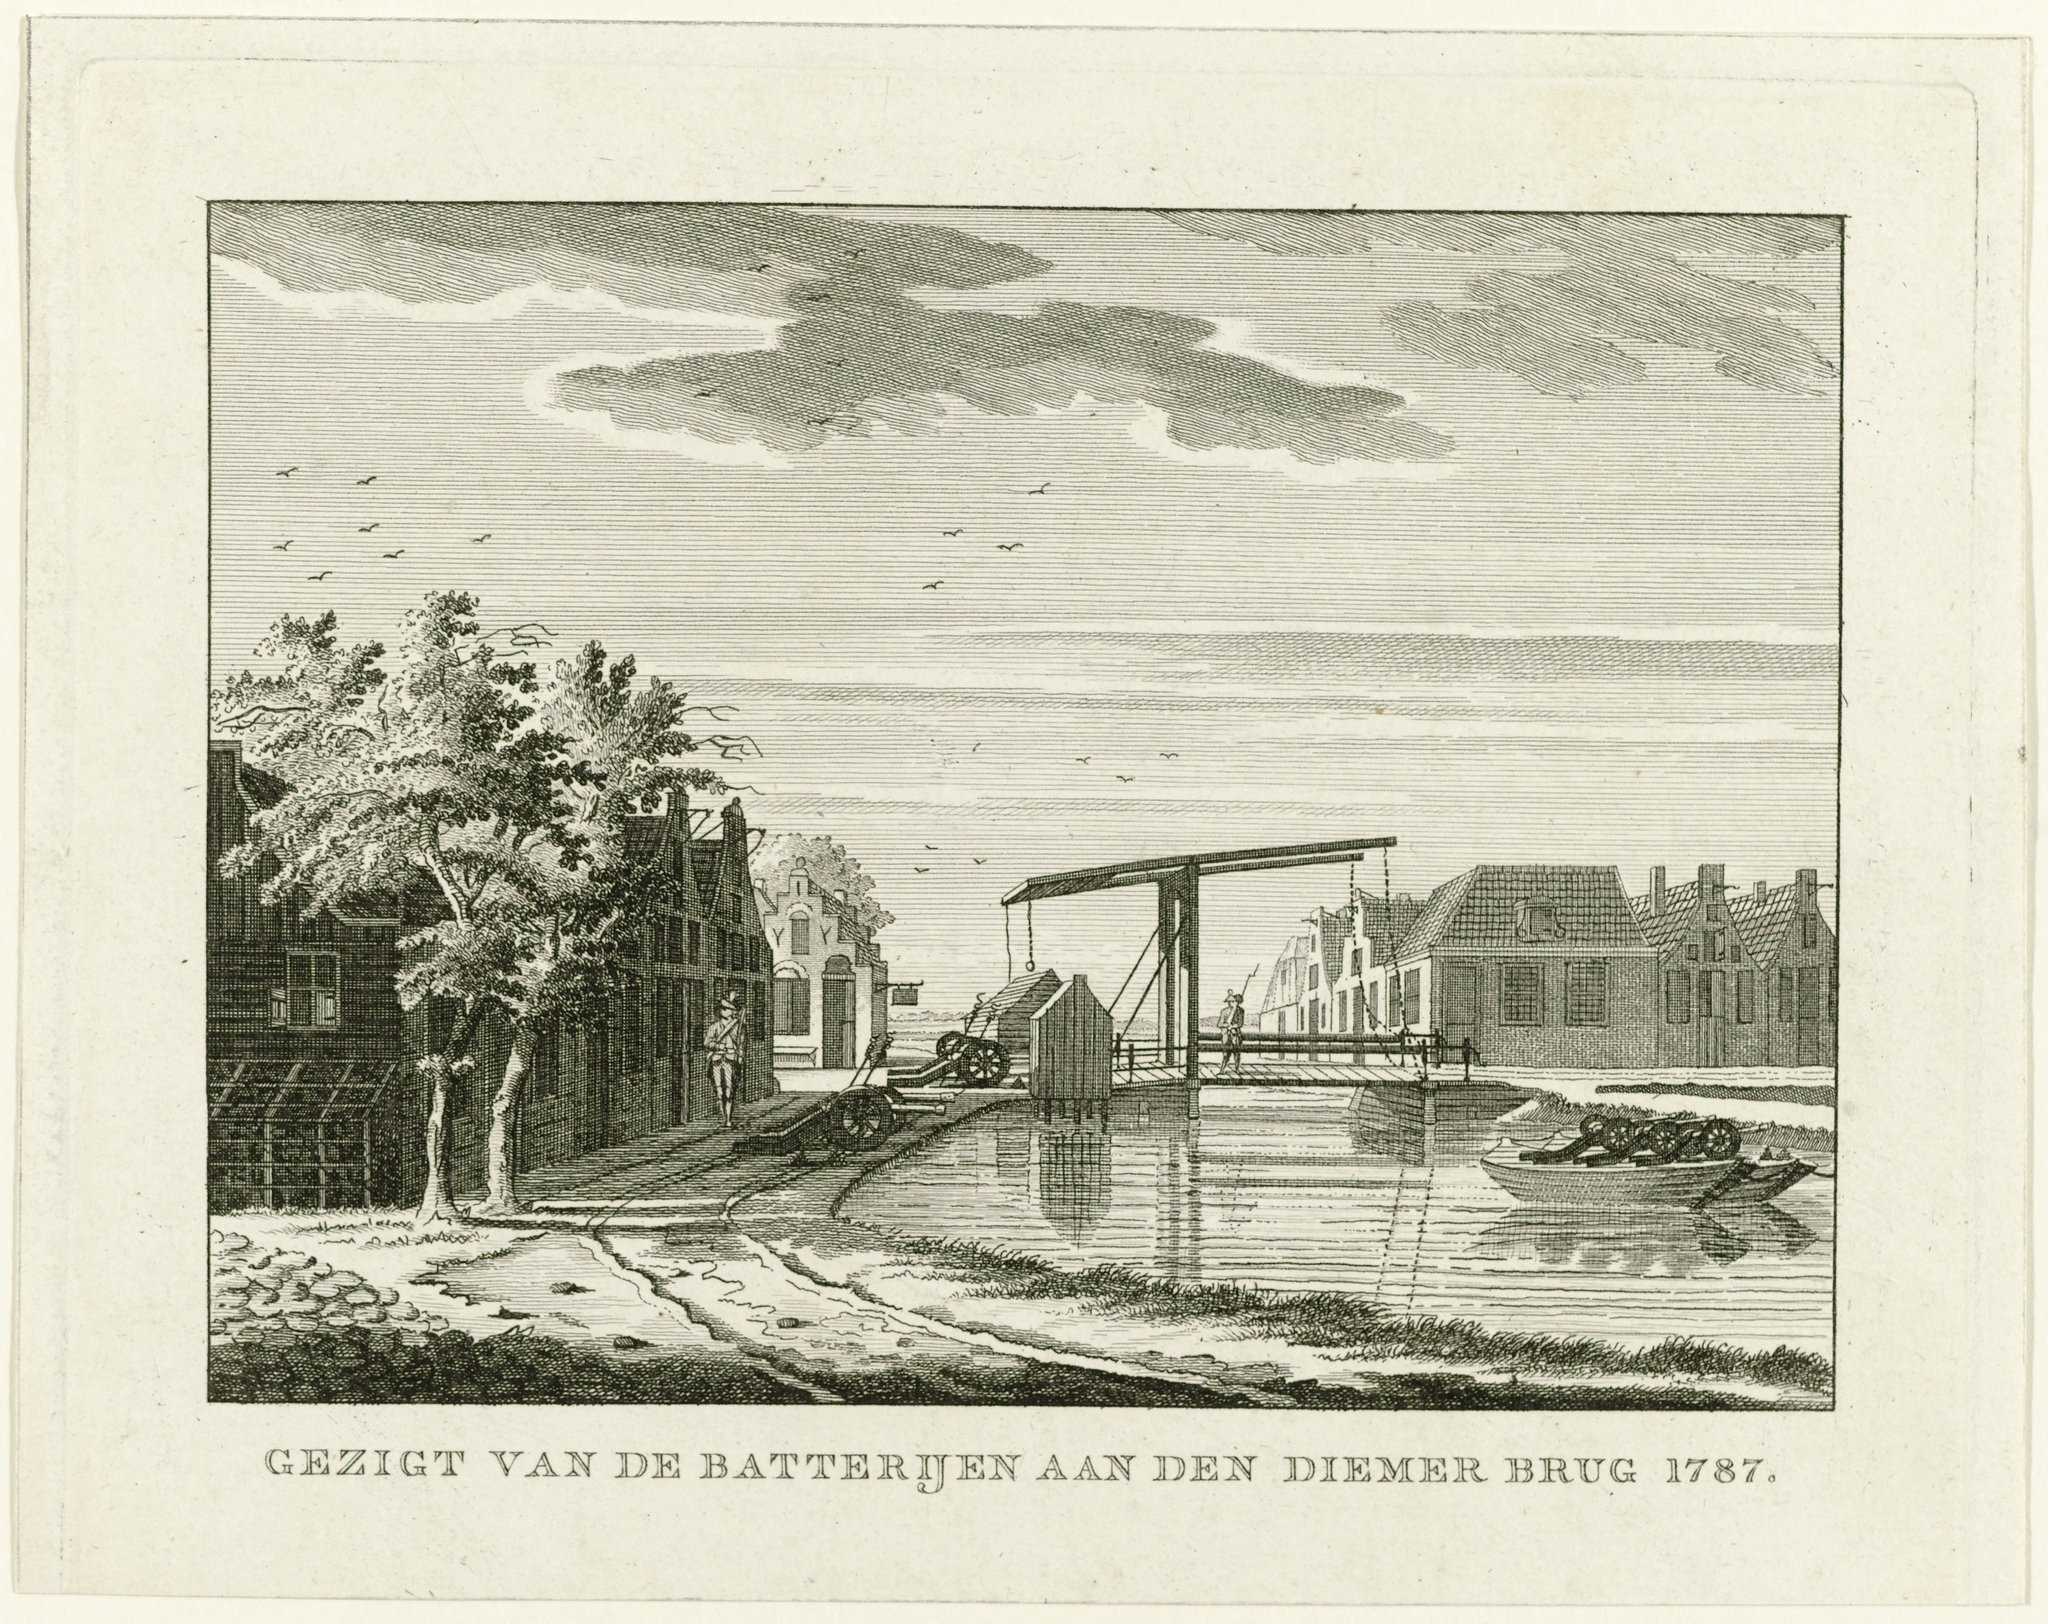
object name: print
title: Batterijen rondom Amsterdam in 1787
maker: Anonymous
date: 1787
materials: paper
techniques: etching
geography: northern netherlands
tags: defence of fortification or city, defensive measures (military)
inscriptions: collector's mark: Lugt 2228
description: Battterij aan de Diemerbrug. Onderdeel van een serie van veertien platen van de verdedigingen aangelegd door de patriotten rondom Amsterdam ten tijde van de inval van de Pruisische troepen in september 1787.